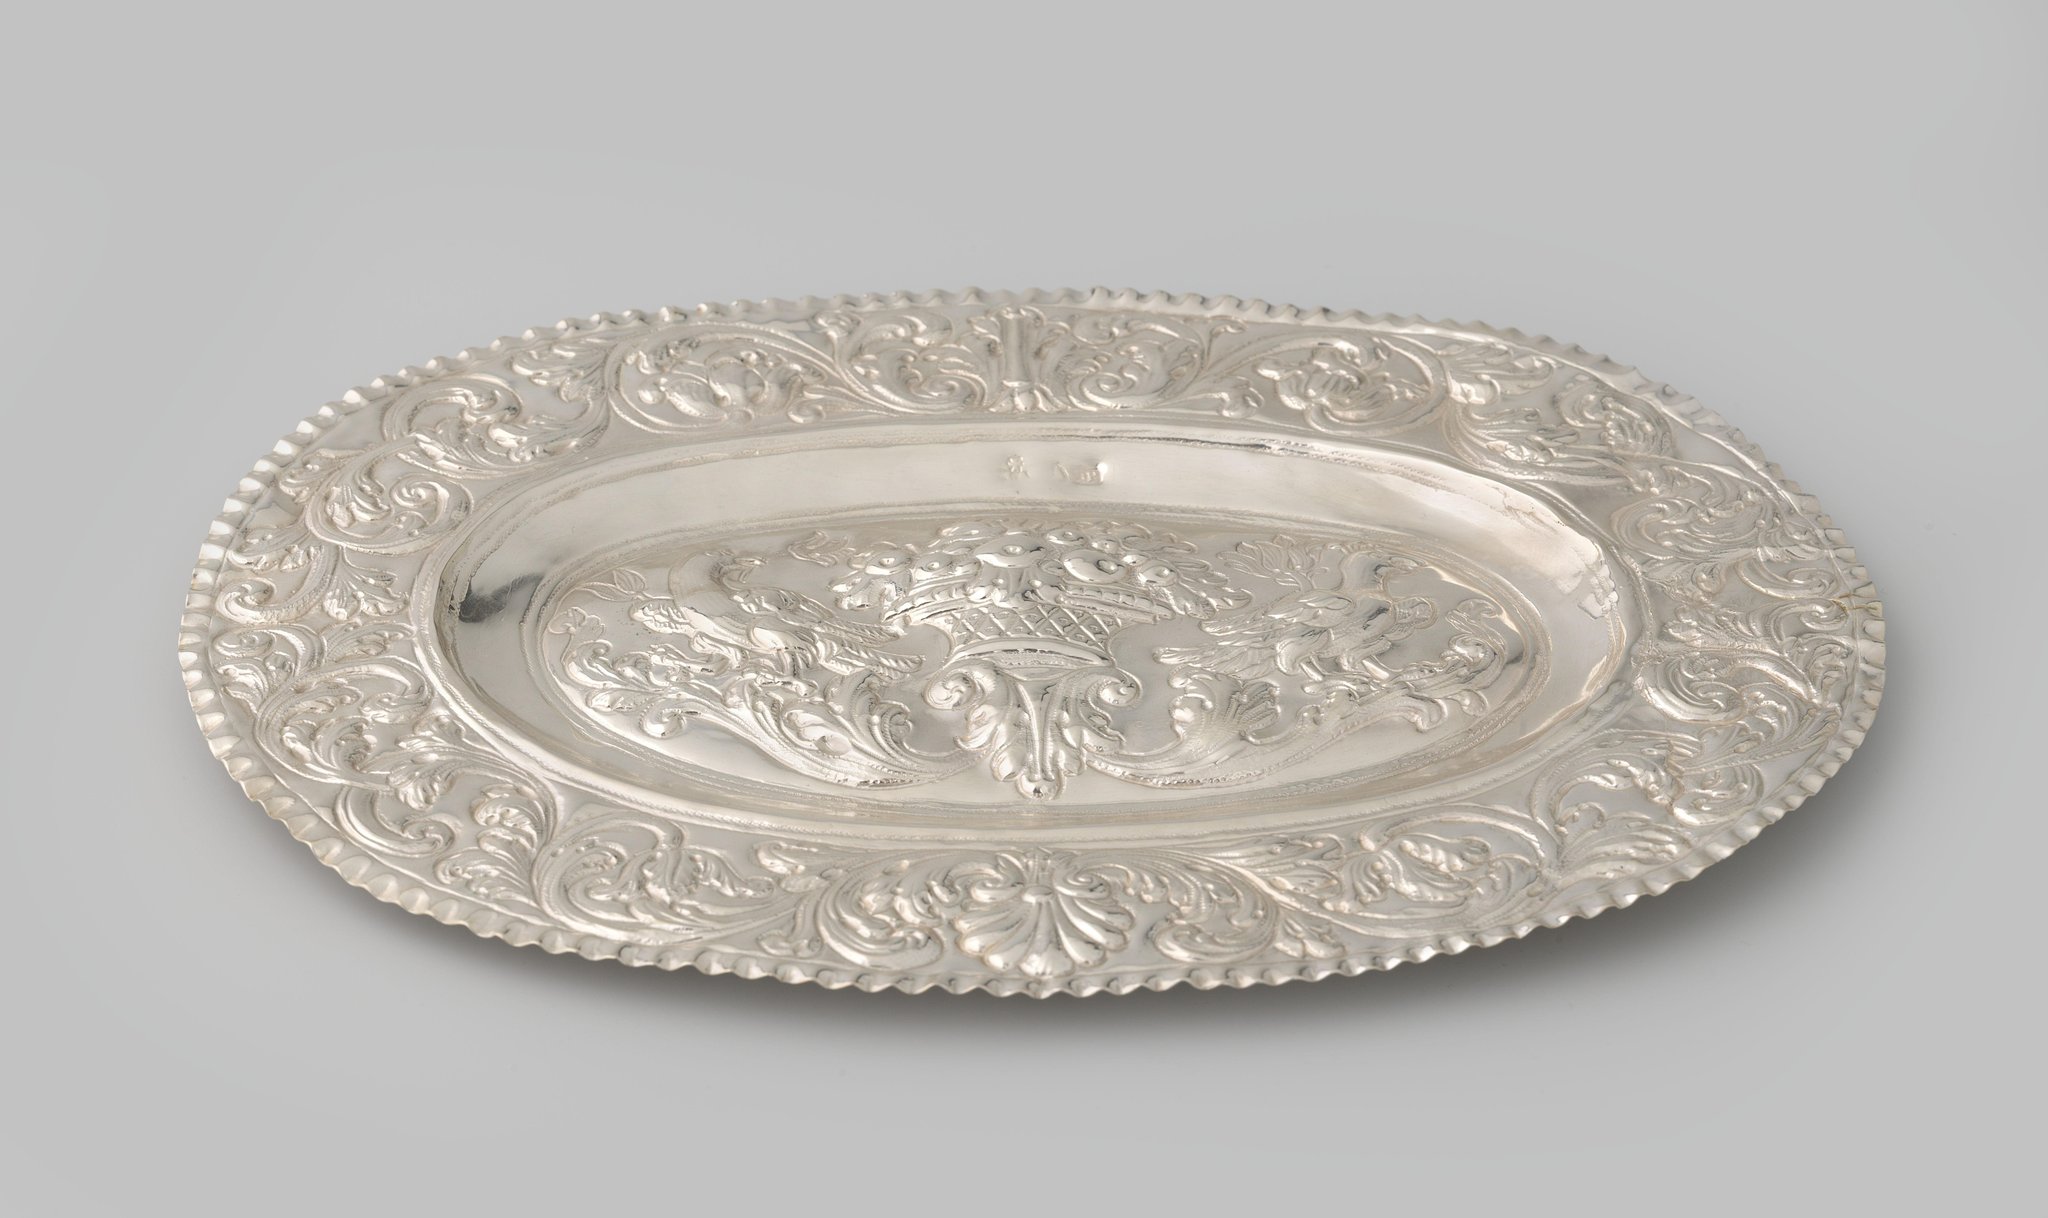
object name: blad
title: Blad van zilver, ovaal met brede platte rand met gedreven bloem- en bladranken. Op het licht gewelfde plat een vruchtenmand geflankeerd door twee vogels.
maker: Anonymous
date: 1700-1750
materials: silver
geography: malta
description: Ovaal blad van zilver. Het blad heeft een brede platte rand versierd met gedreven bloem- en bladranken. Op het licht gewelfde plat is een vruchtenmand weergegeven geflankeerd door 2 vogels.